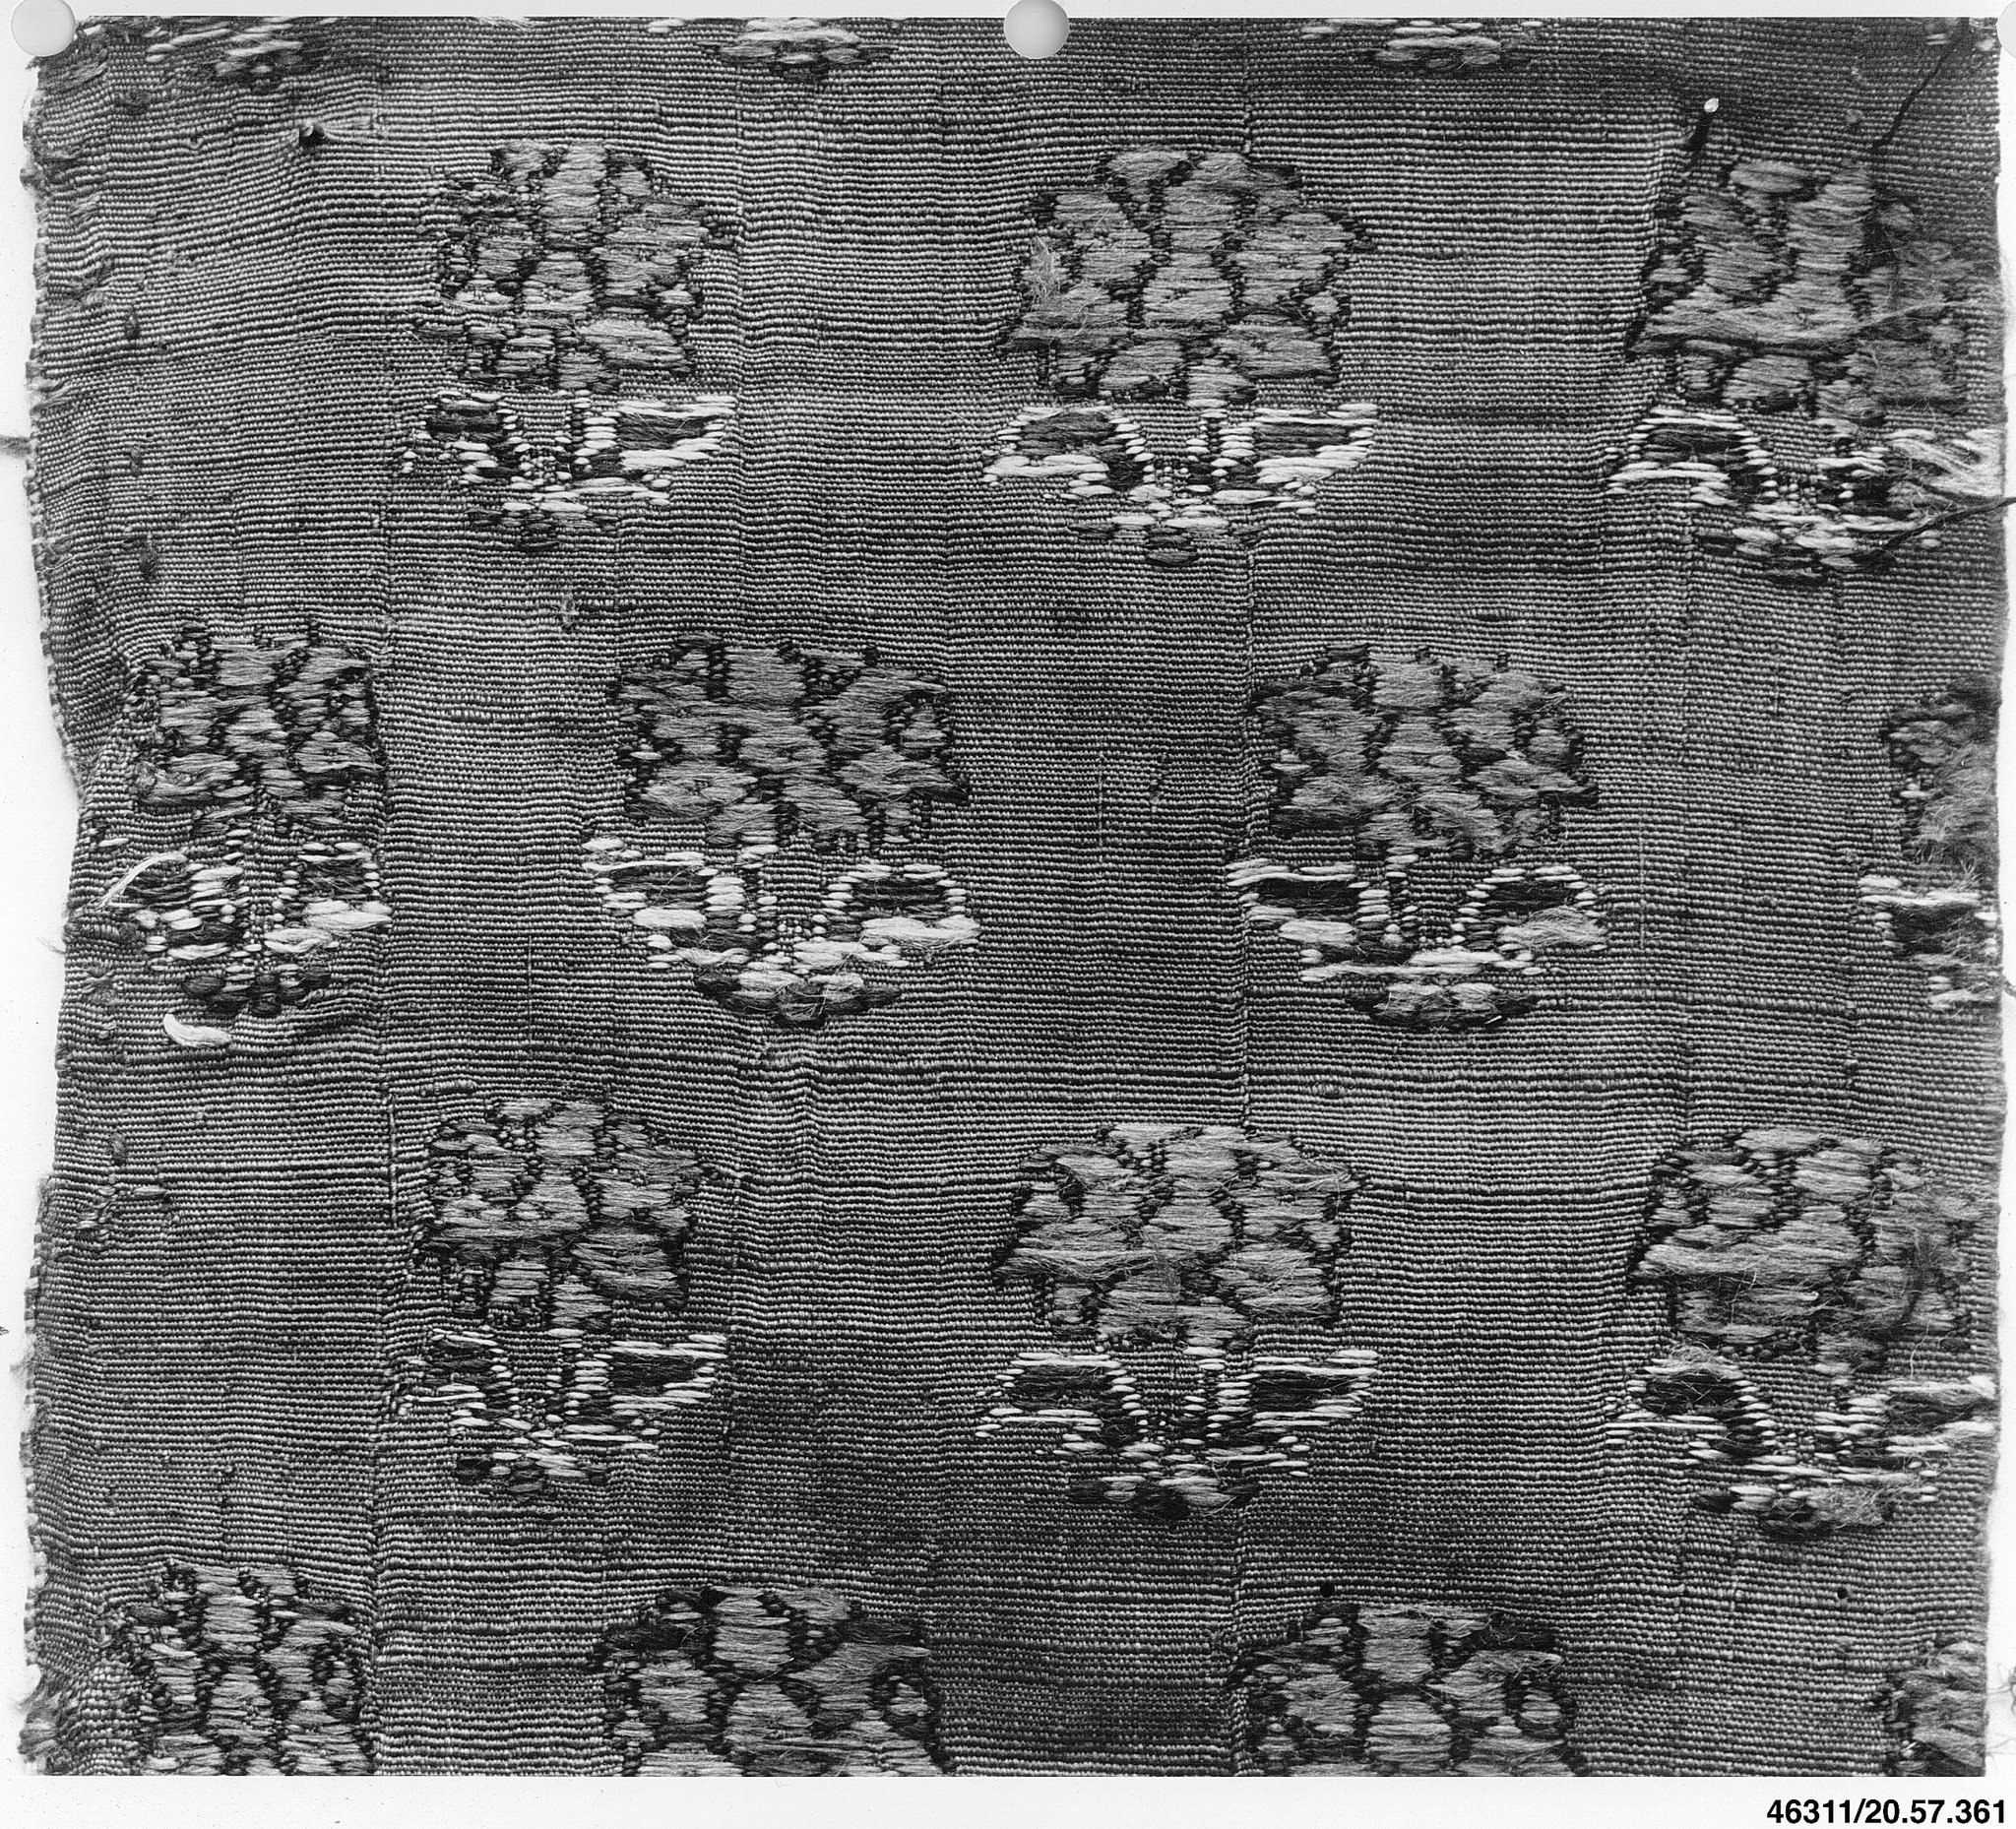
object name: piece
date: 1775-1800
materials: silk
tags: flowers,leaves